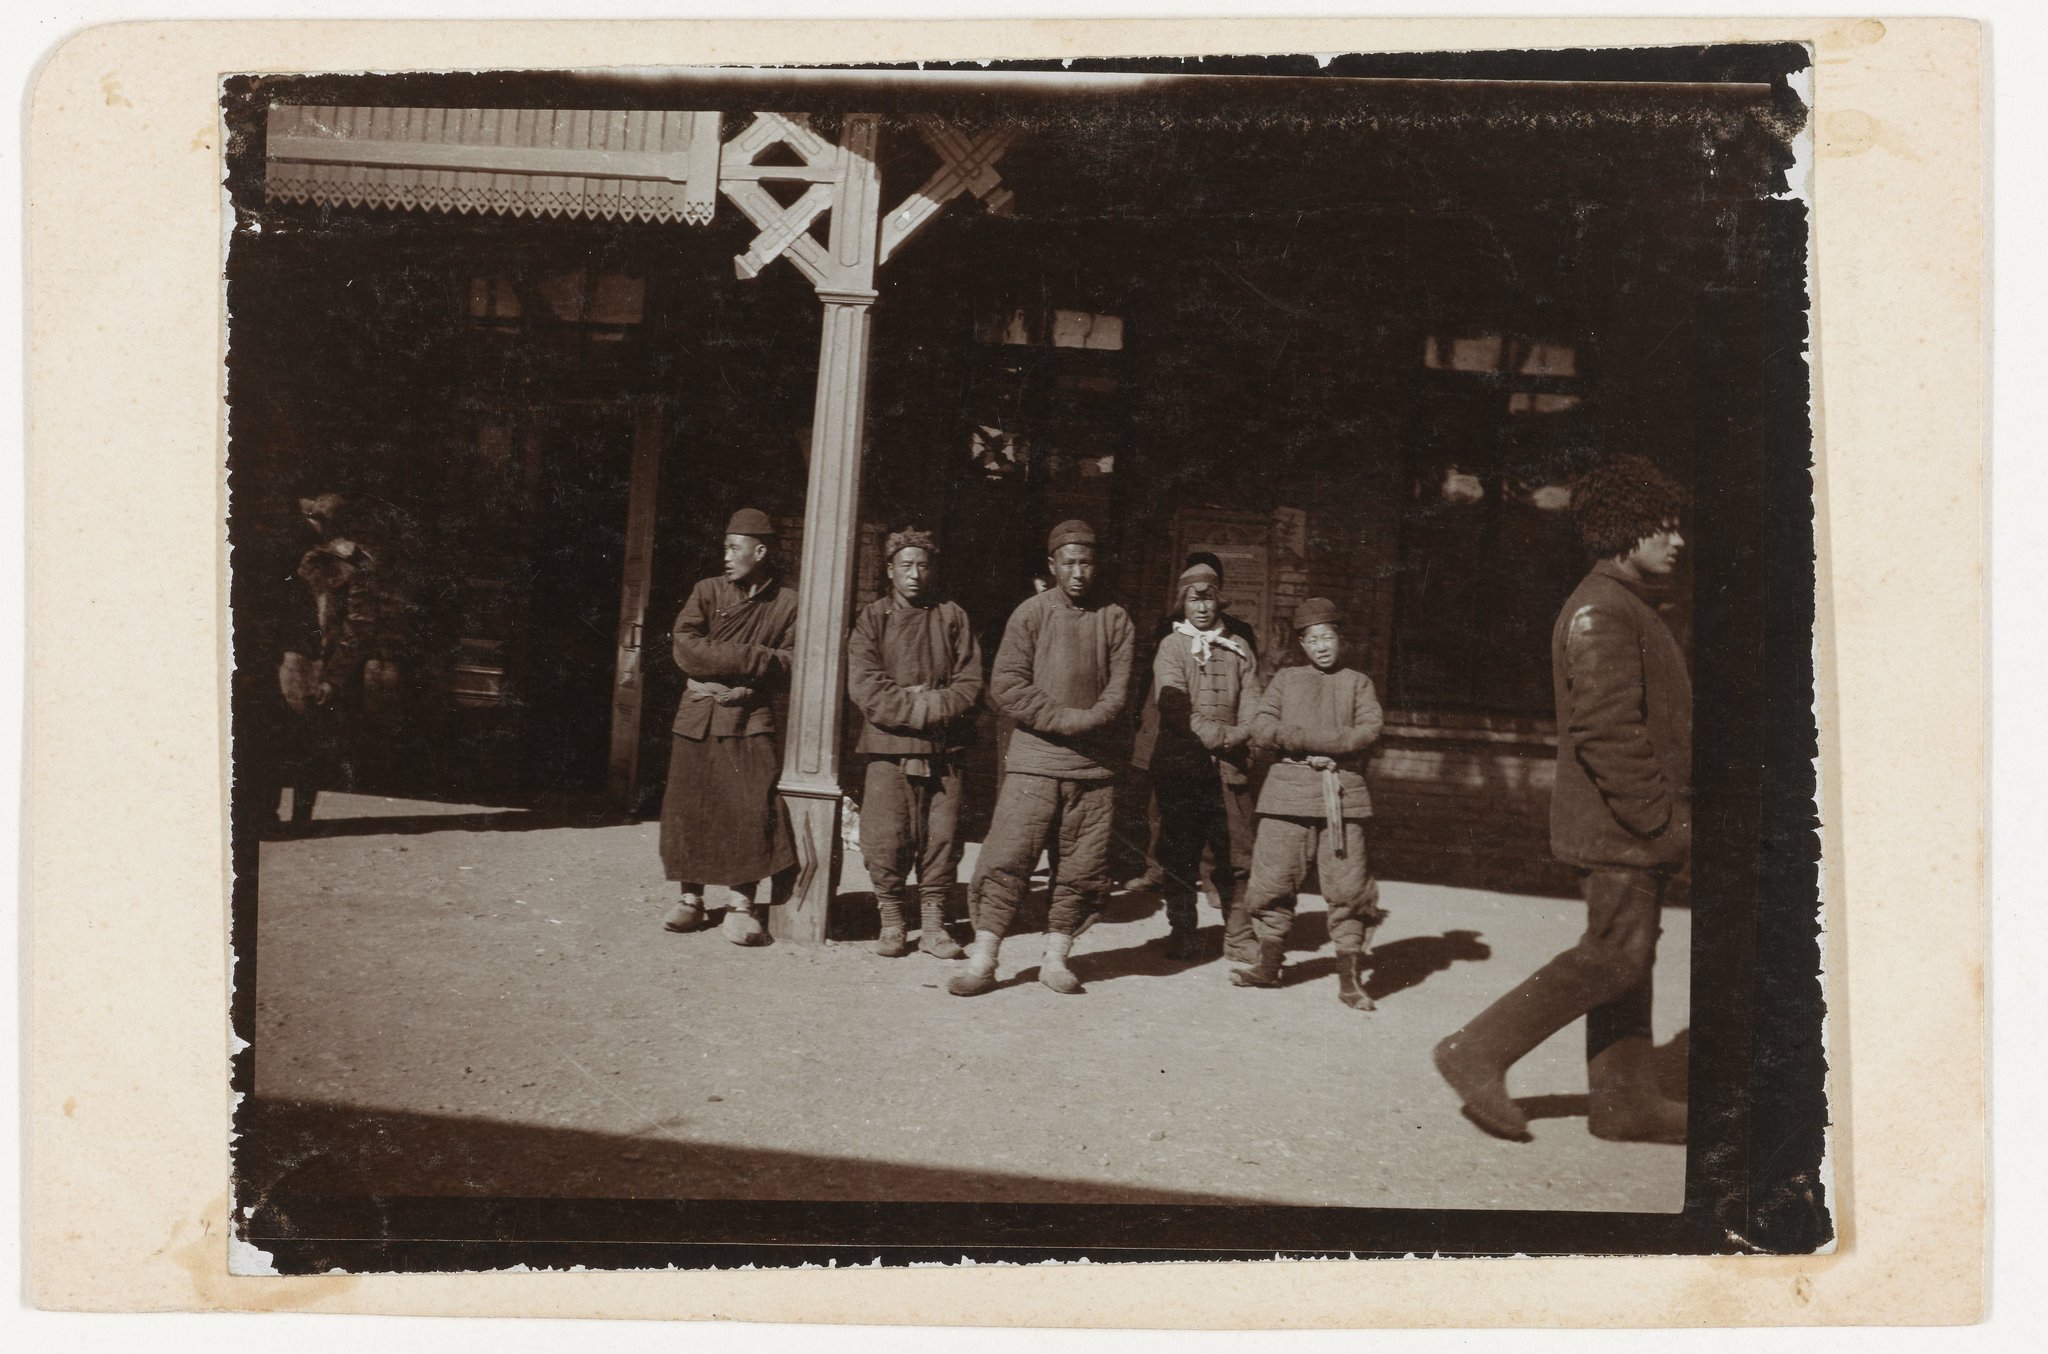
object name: photograph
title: Portret van een groepje wachtende mannen en jongens, China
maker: jan adriani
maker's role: fotograaf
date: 1907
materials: cardboard, photographic support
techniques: collodion silver print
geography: china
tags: anonymous historical persons portrayed in a group, in a group-portrait, china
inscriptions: inscription: ‘Bestuurderen der Maatschappij "Arti et Amicit (...) op zondag 8 april 1906 [...] de opening der tentoonstelling van kunstwer (...)’